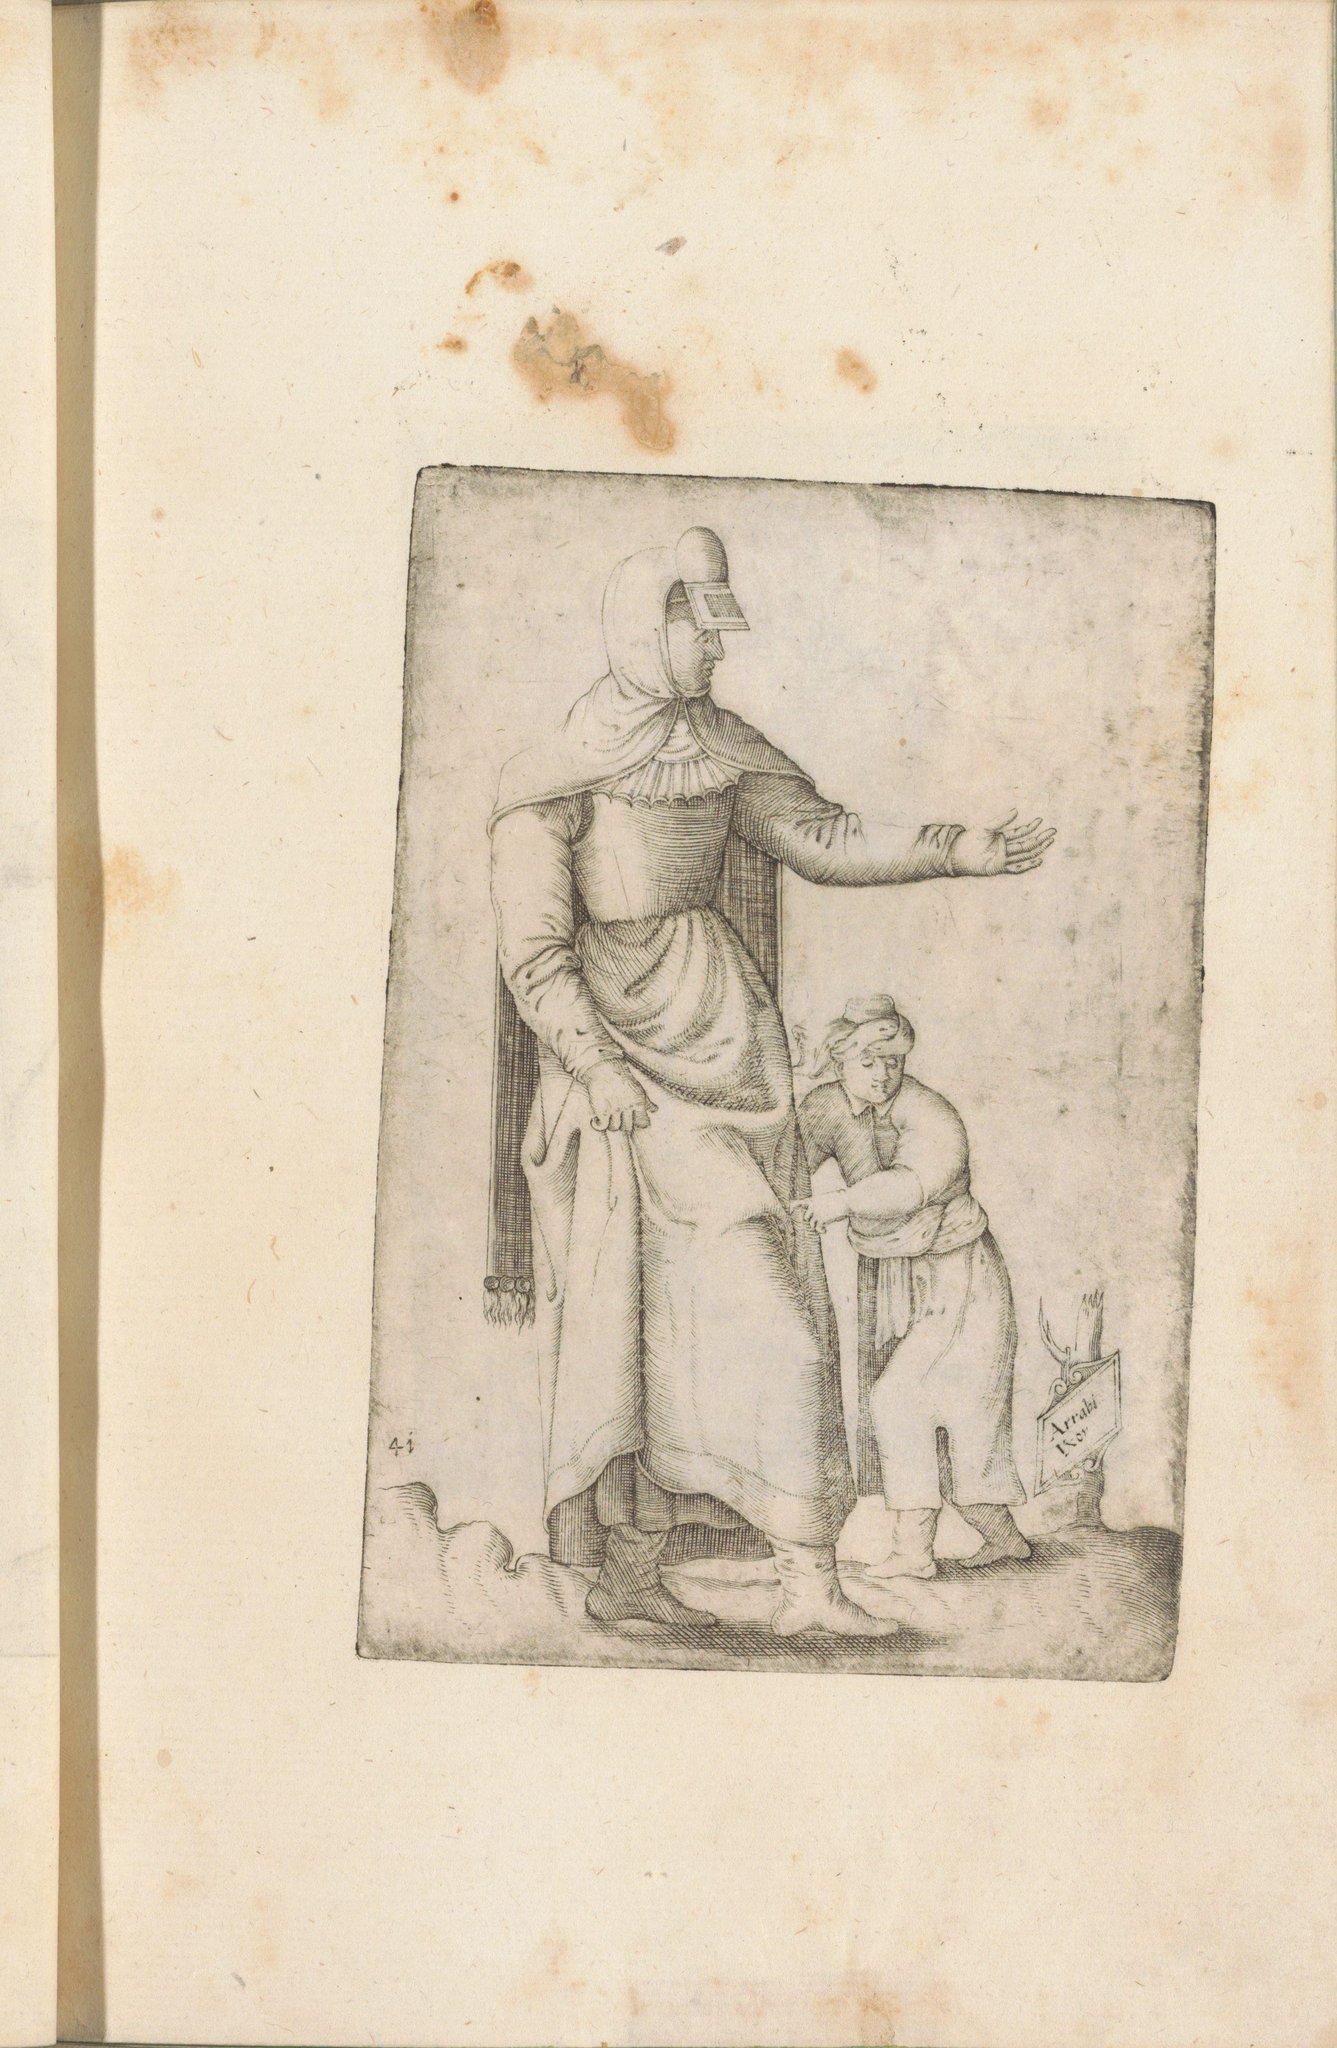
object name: costume print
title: Omnium fere gentium nostrae aetatis habitus, nunquam ante hac aediti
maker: ferando bertelli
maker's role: print maker, publisher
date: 1569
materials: paper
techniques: engraving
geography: venice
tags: fashion plates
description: Arabische vrouw met kind. Onderdeel van het kostuumboek getiteld 'Omnium fere gentium nostrae aetatis habitus, nunquam ante hac aediti', Venetië 1569. Heruitgave uit 1569 van de eerste editie uit 1563.